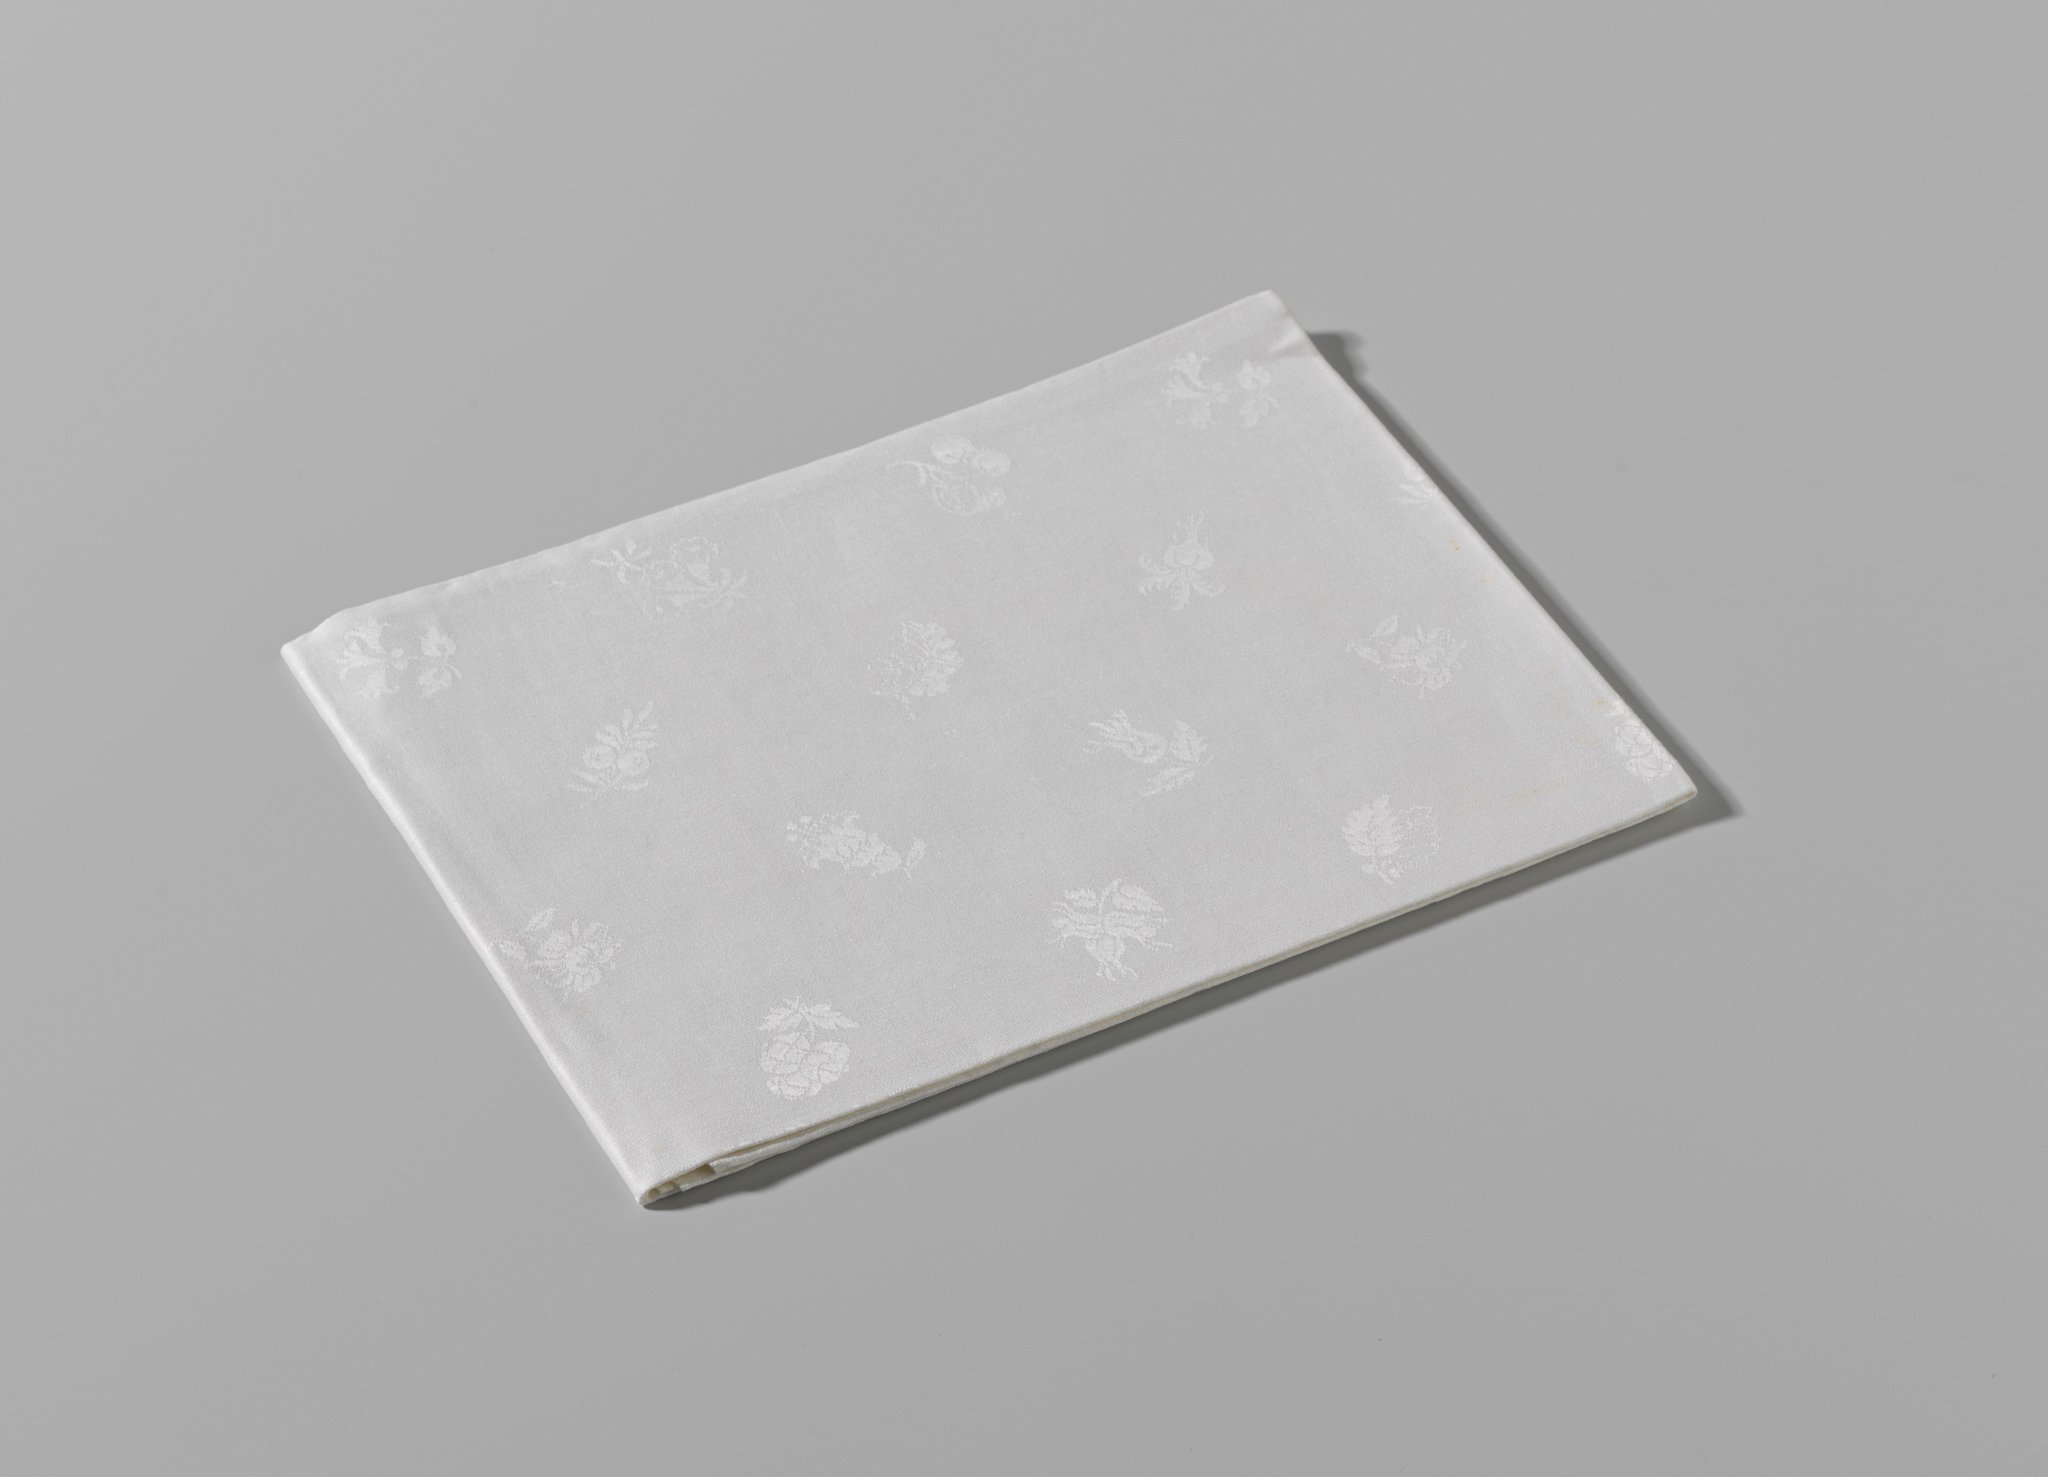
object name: napkin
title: Servet met patroon van diverse vruchten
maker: Anonymous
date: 1800-1900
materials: linen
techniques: damask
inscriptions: label: ‘R.M. A'dam’, mark: ‘36’, monogram: ‘TvBF’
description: Servet van linnendamast met patroon van diverse vruchten en bloemen op het middenveld.